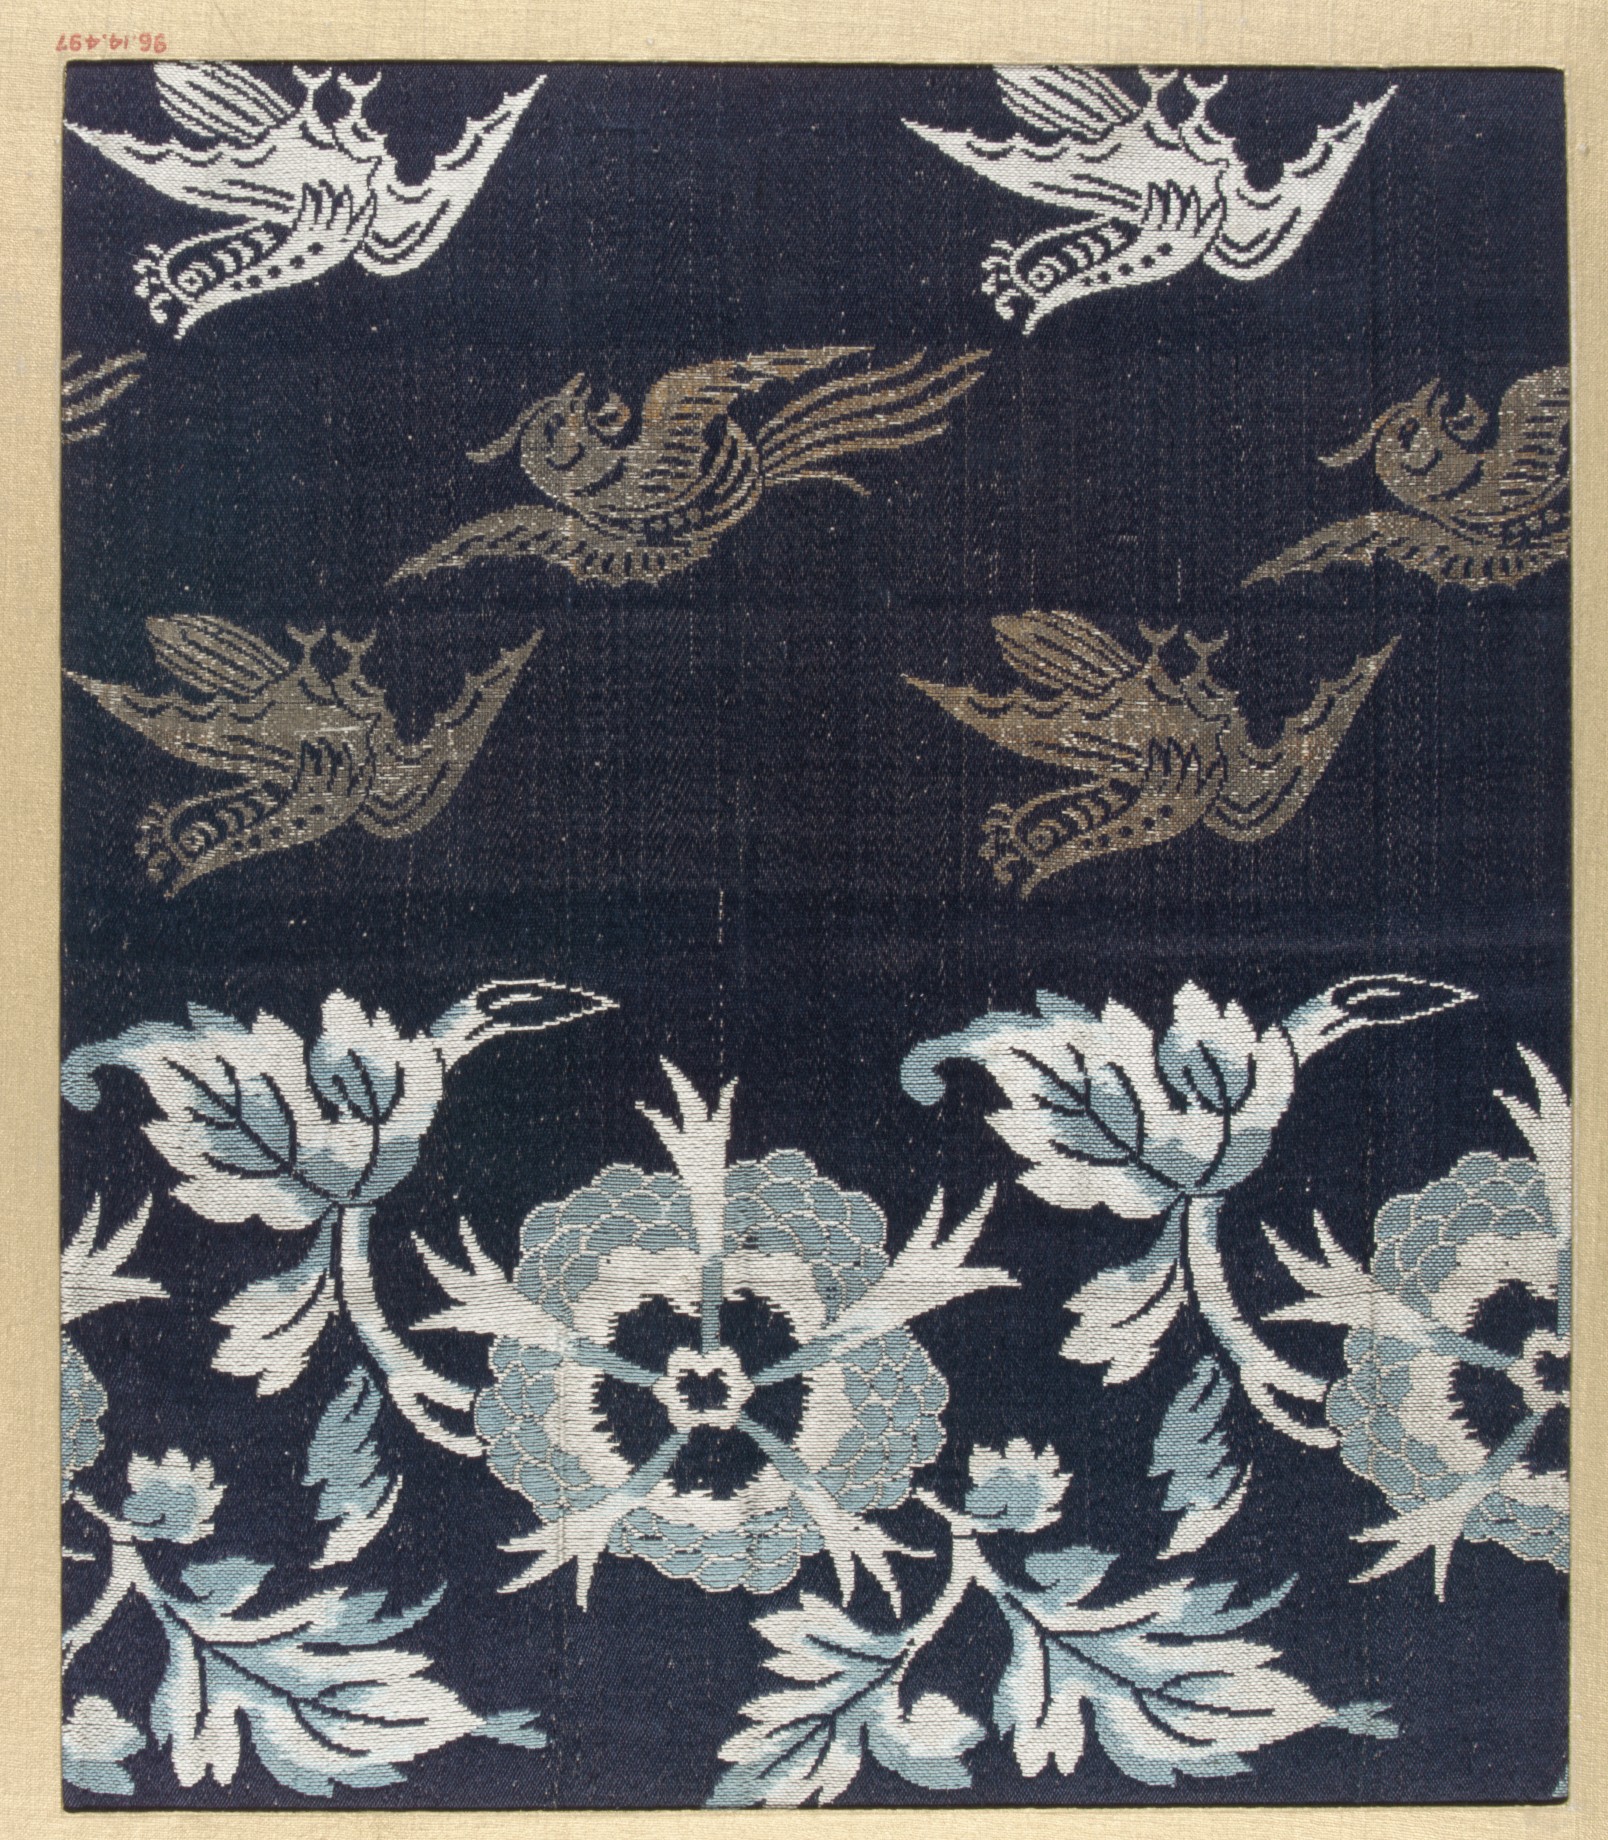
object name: piece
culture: japanese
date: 1701-1900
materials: silk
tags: birds